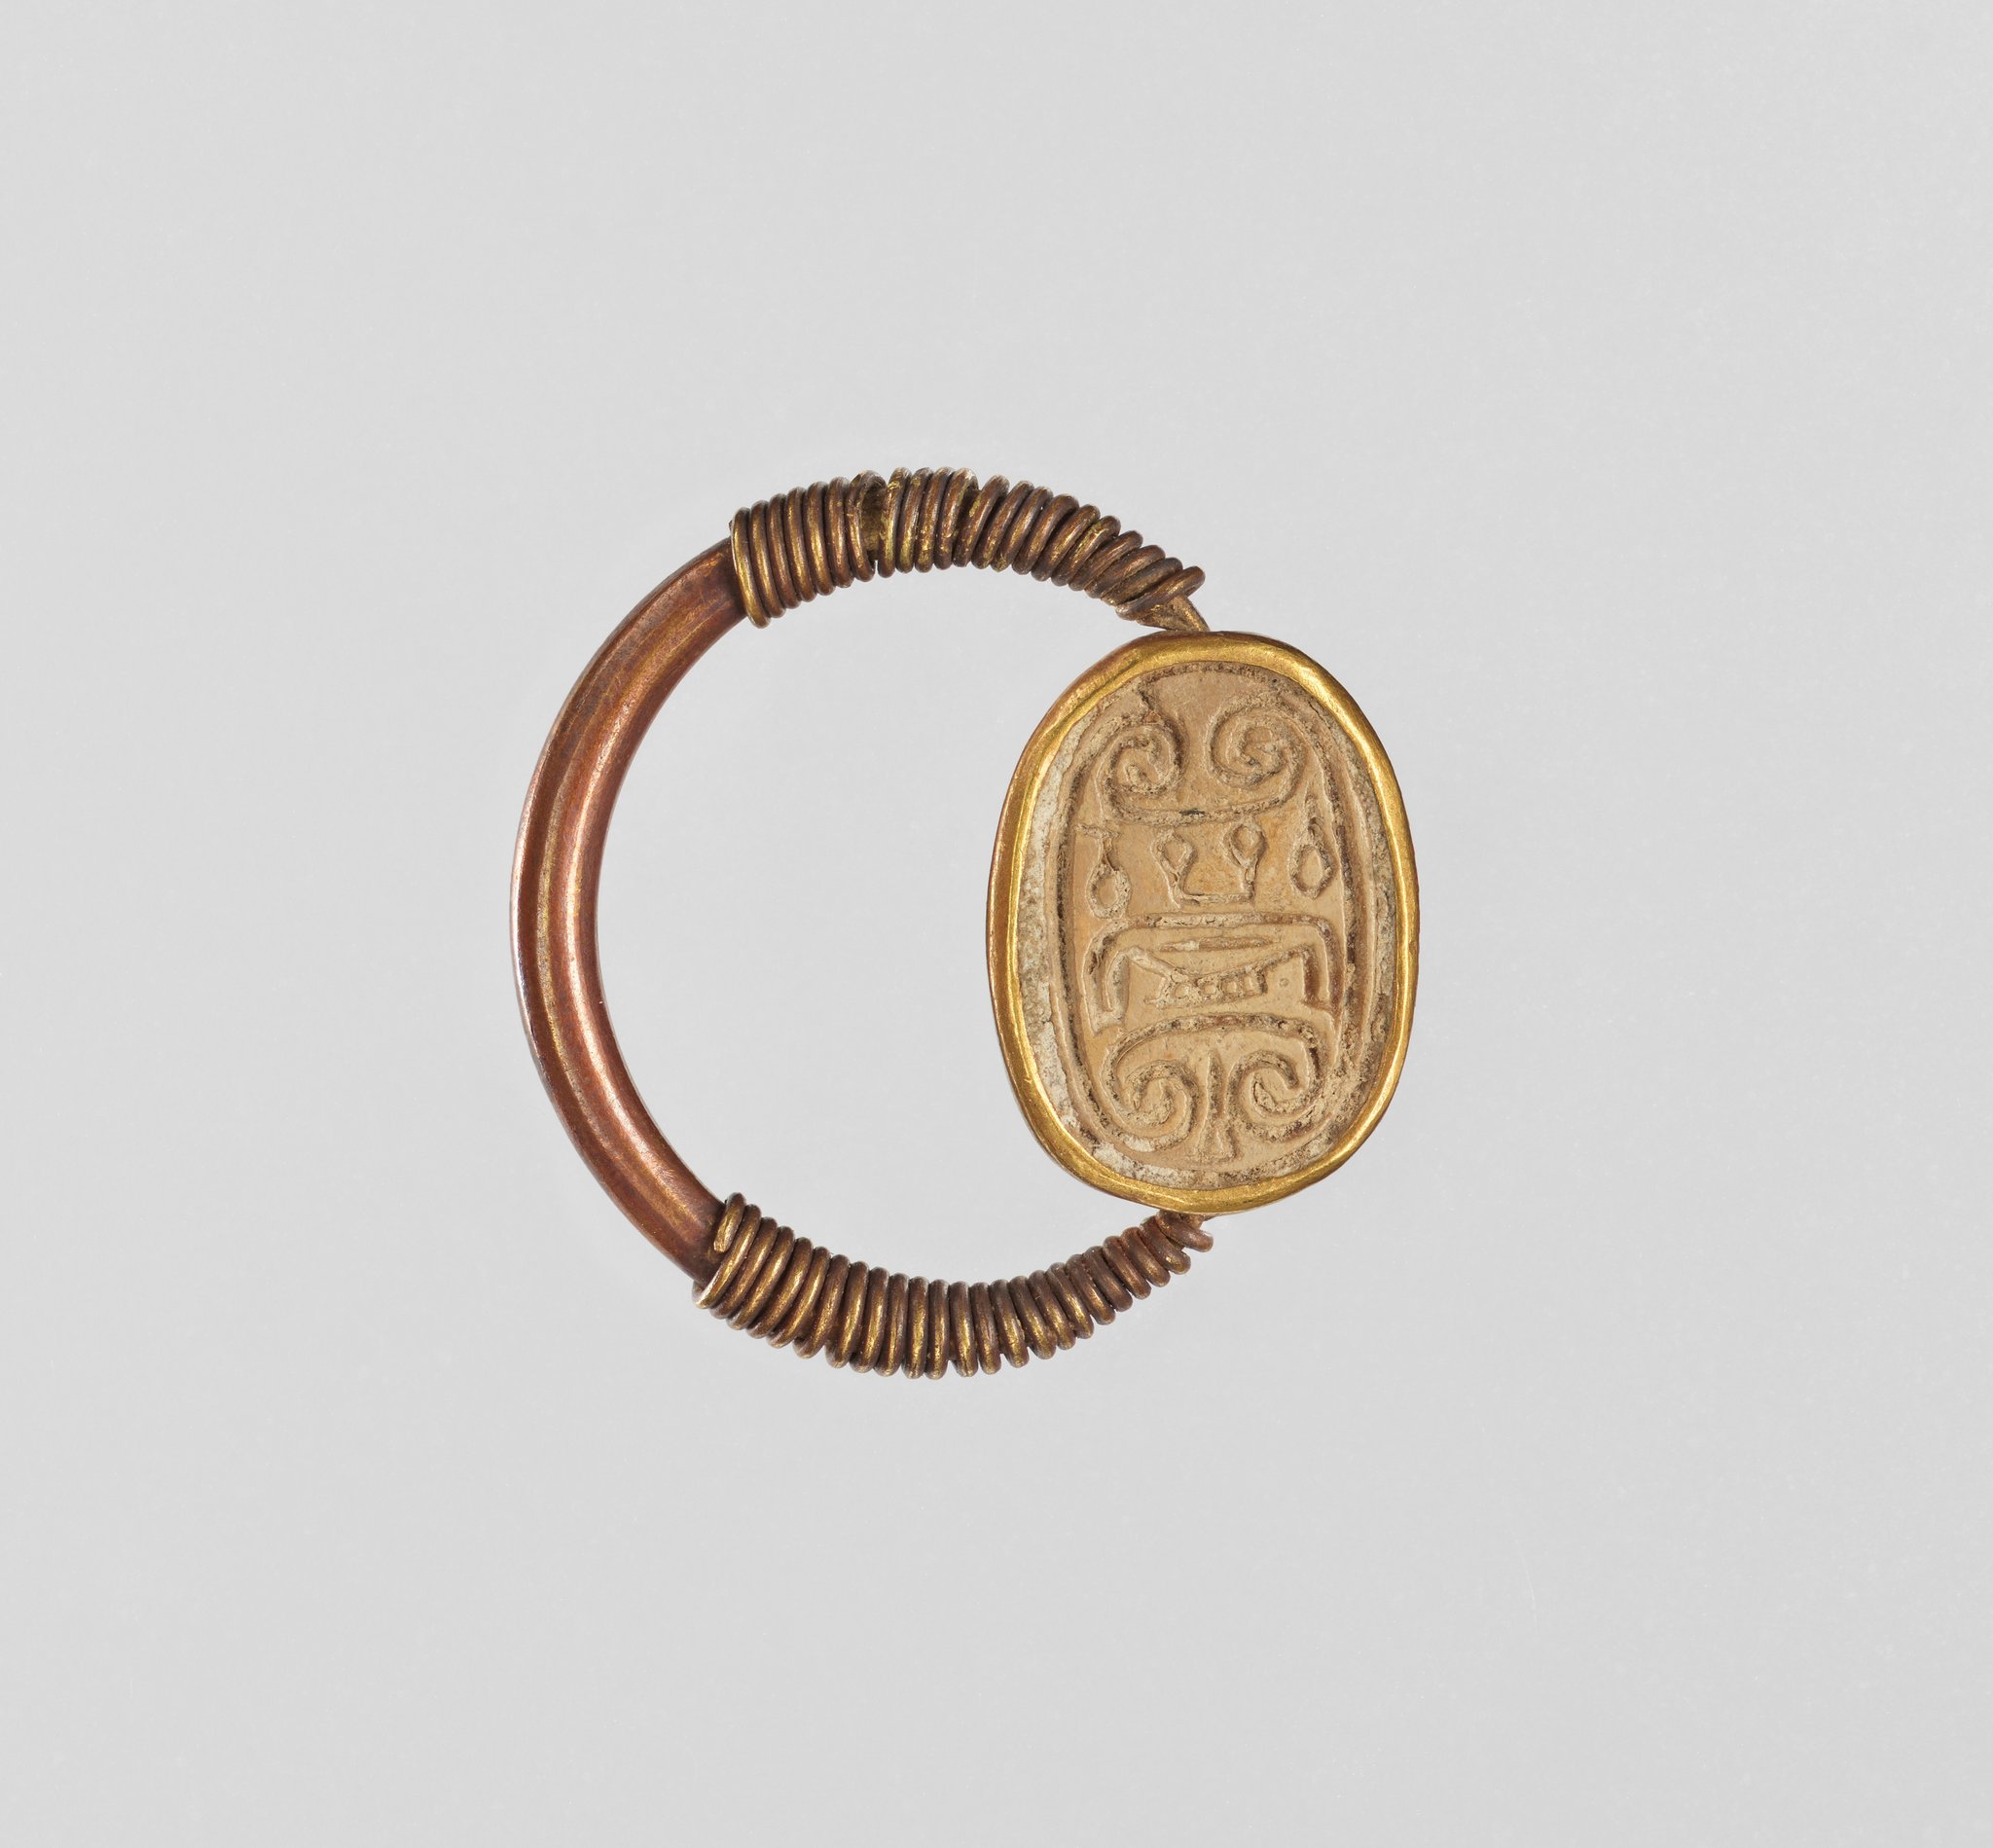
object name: ring with scarab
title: Scarab Finger Ring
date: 1560-1479 BCE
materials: gold, stone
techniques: glazing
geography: egypt